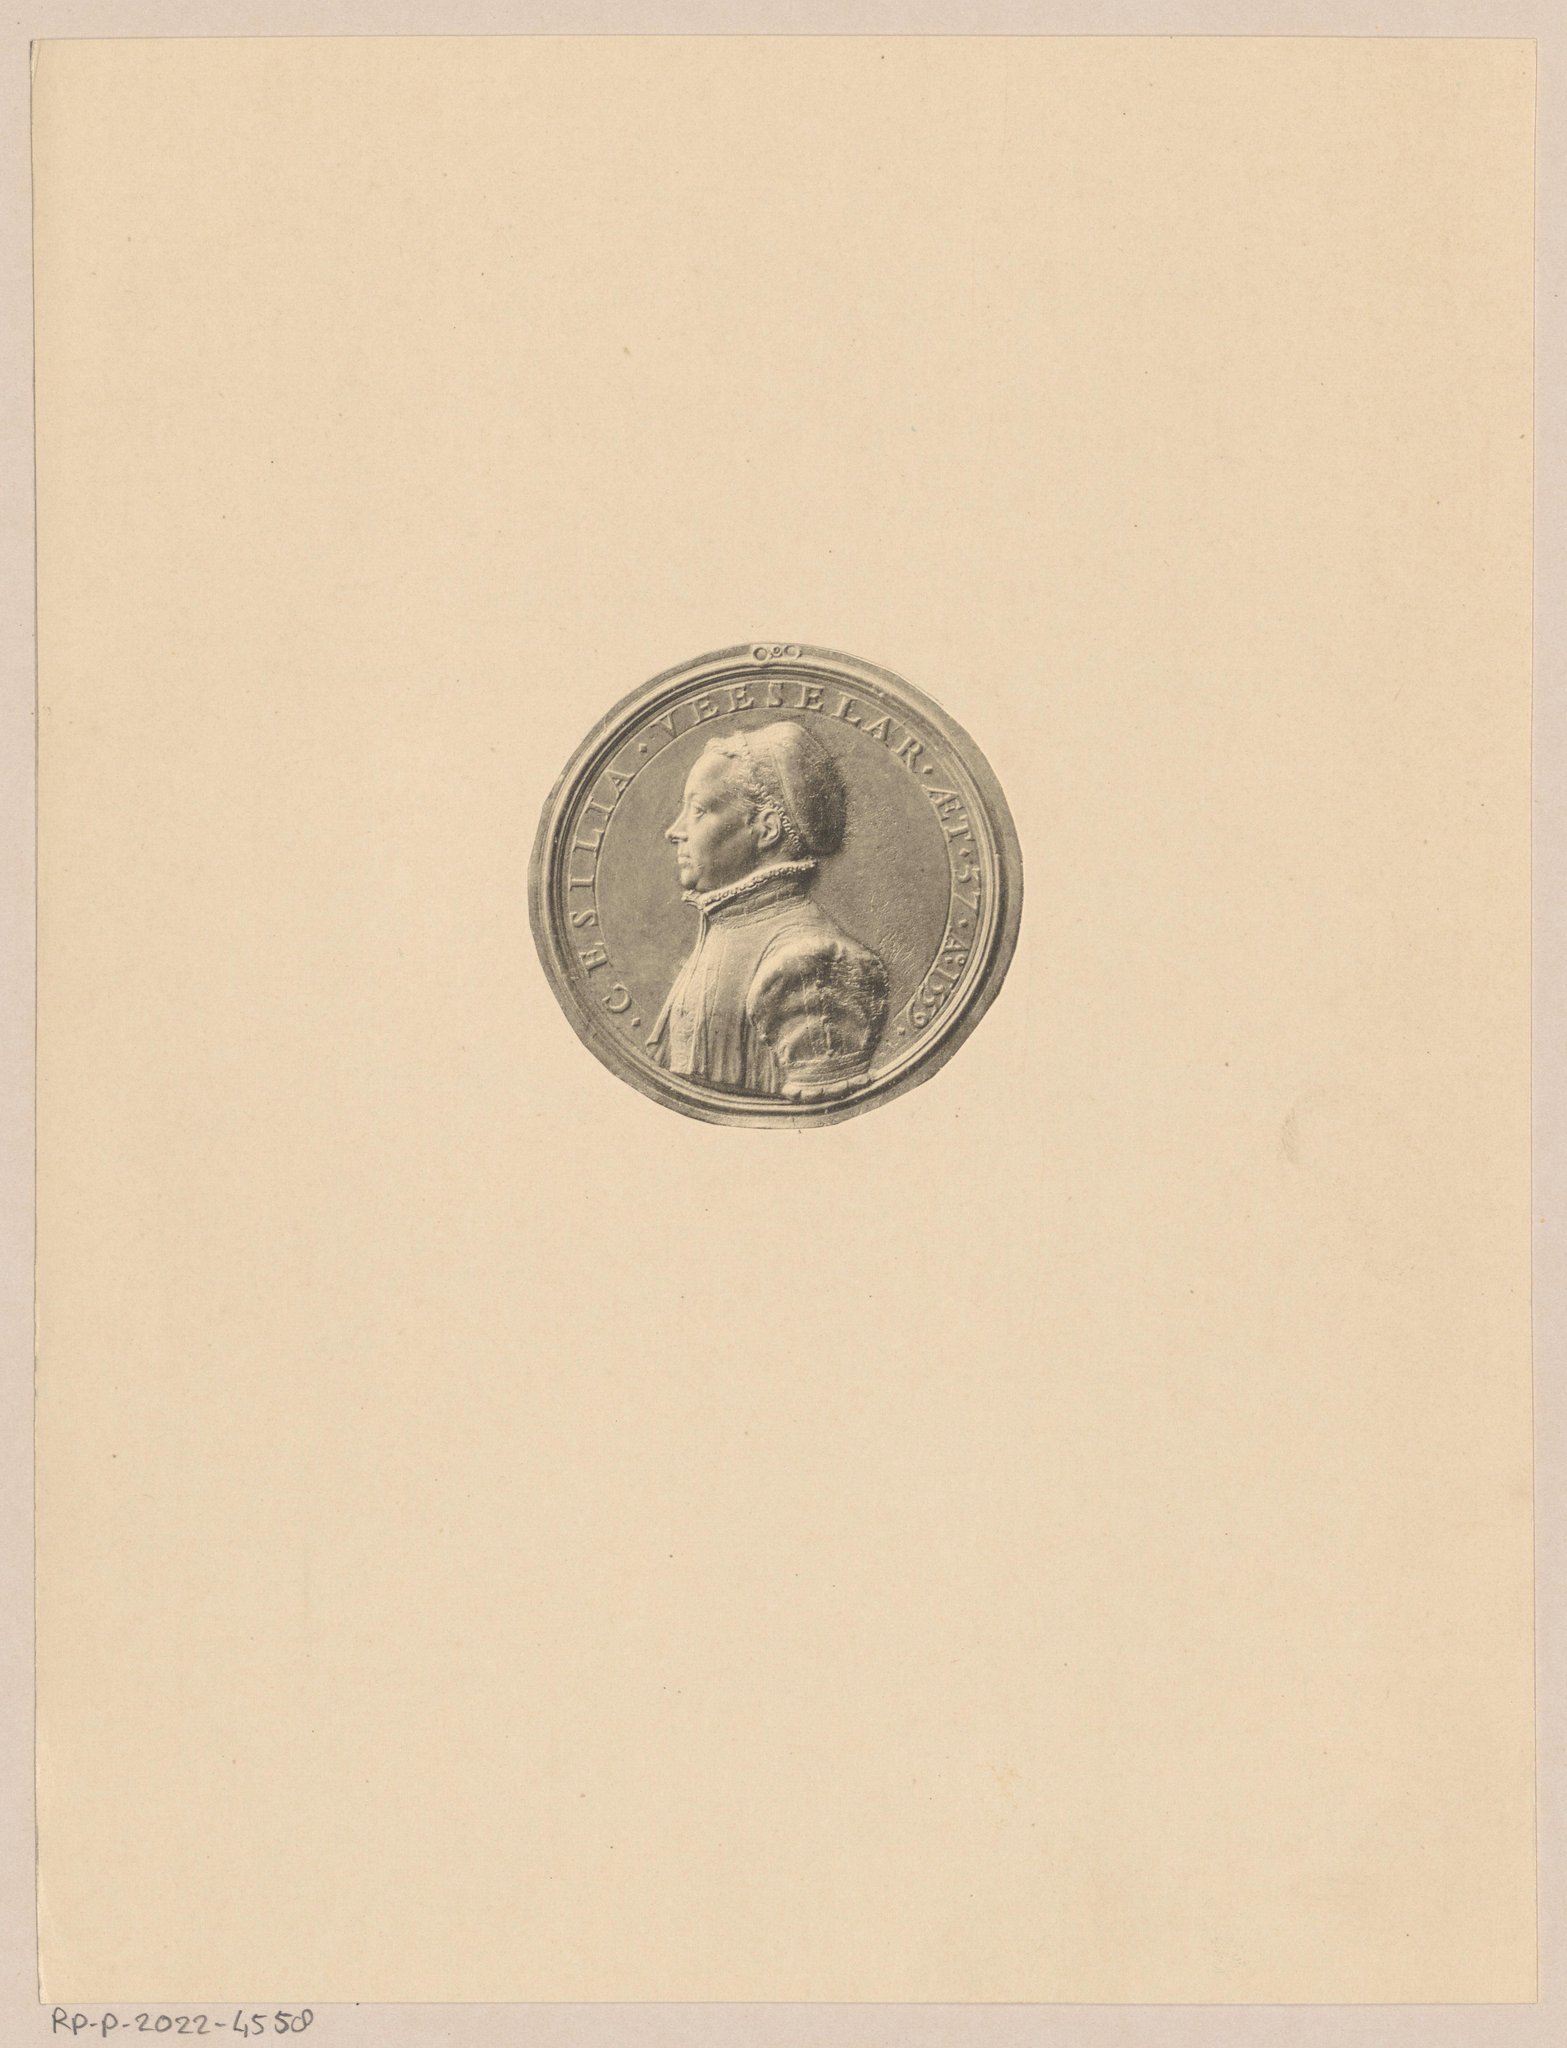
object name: photomechanical print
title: Penning met portret van Cesilia Veeselar op 37-jarige leeftijd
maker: Anonymous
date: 1875-1930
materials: paper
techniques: photograph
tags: historical persons - bb - woman, pendant, trinket, 'breloque'